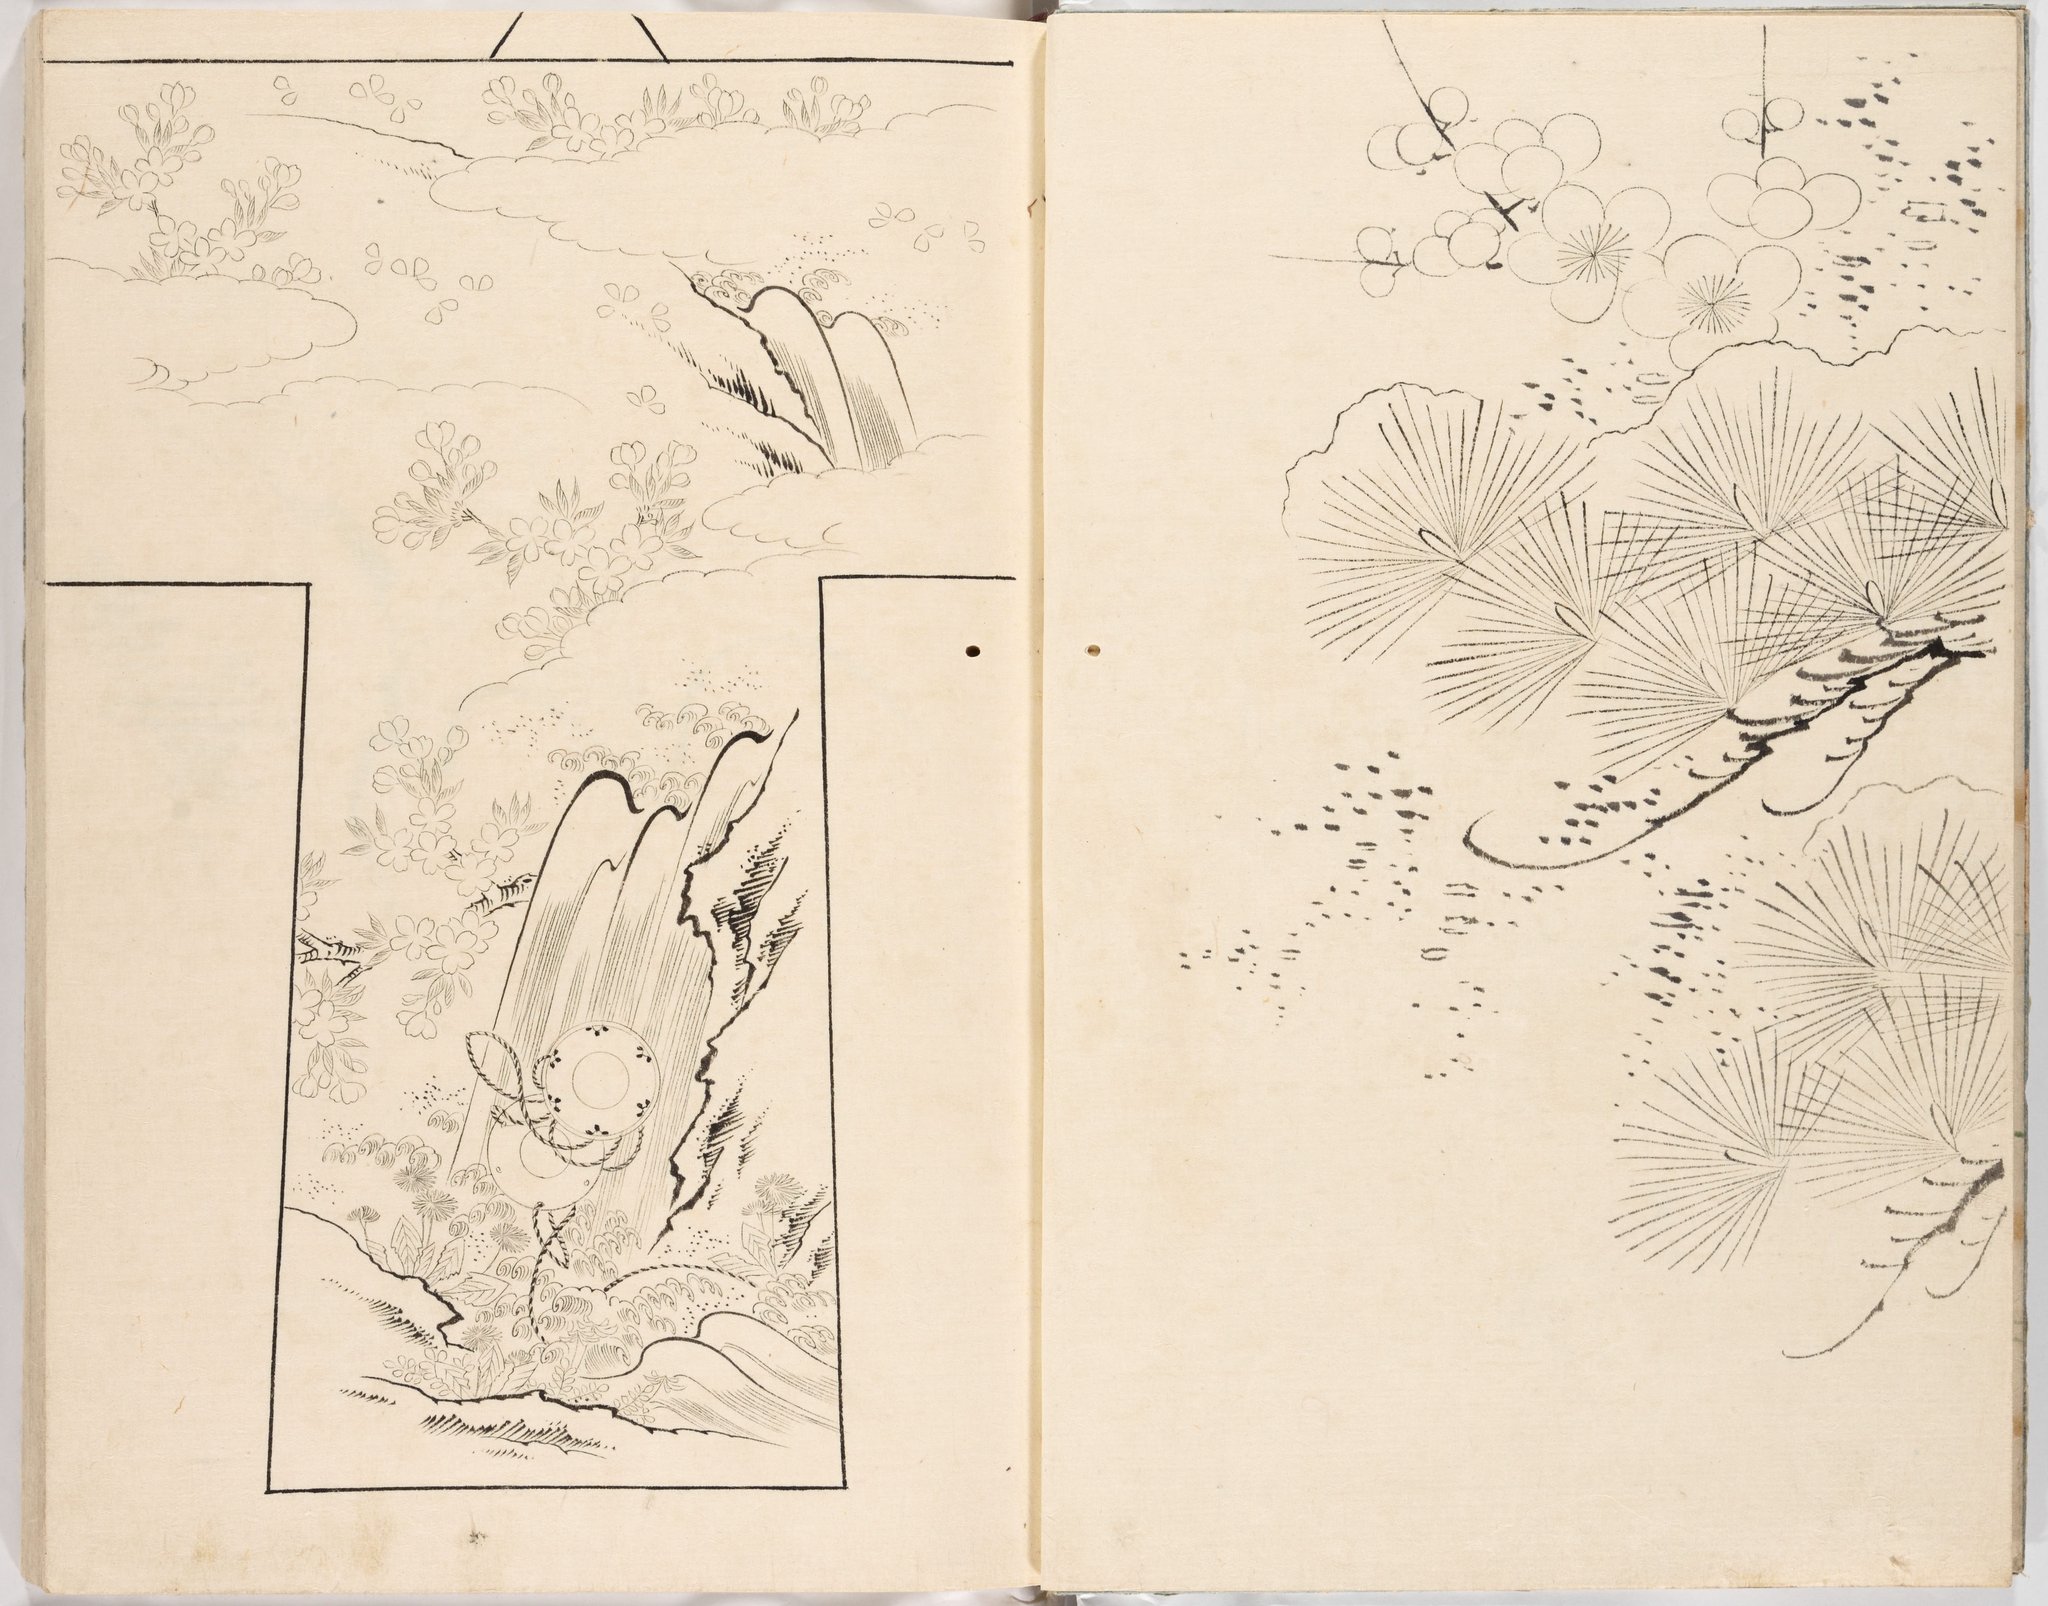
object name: illustrated book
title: Hinagata chō (Model Book)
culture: japanese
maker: unidentified artist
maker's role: artist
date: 1801-1900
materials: ink, paper